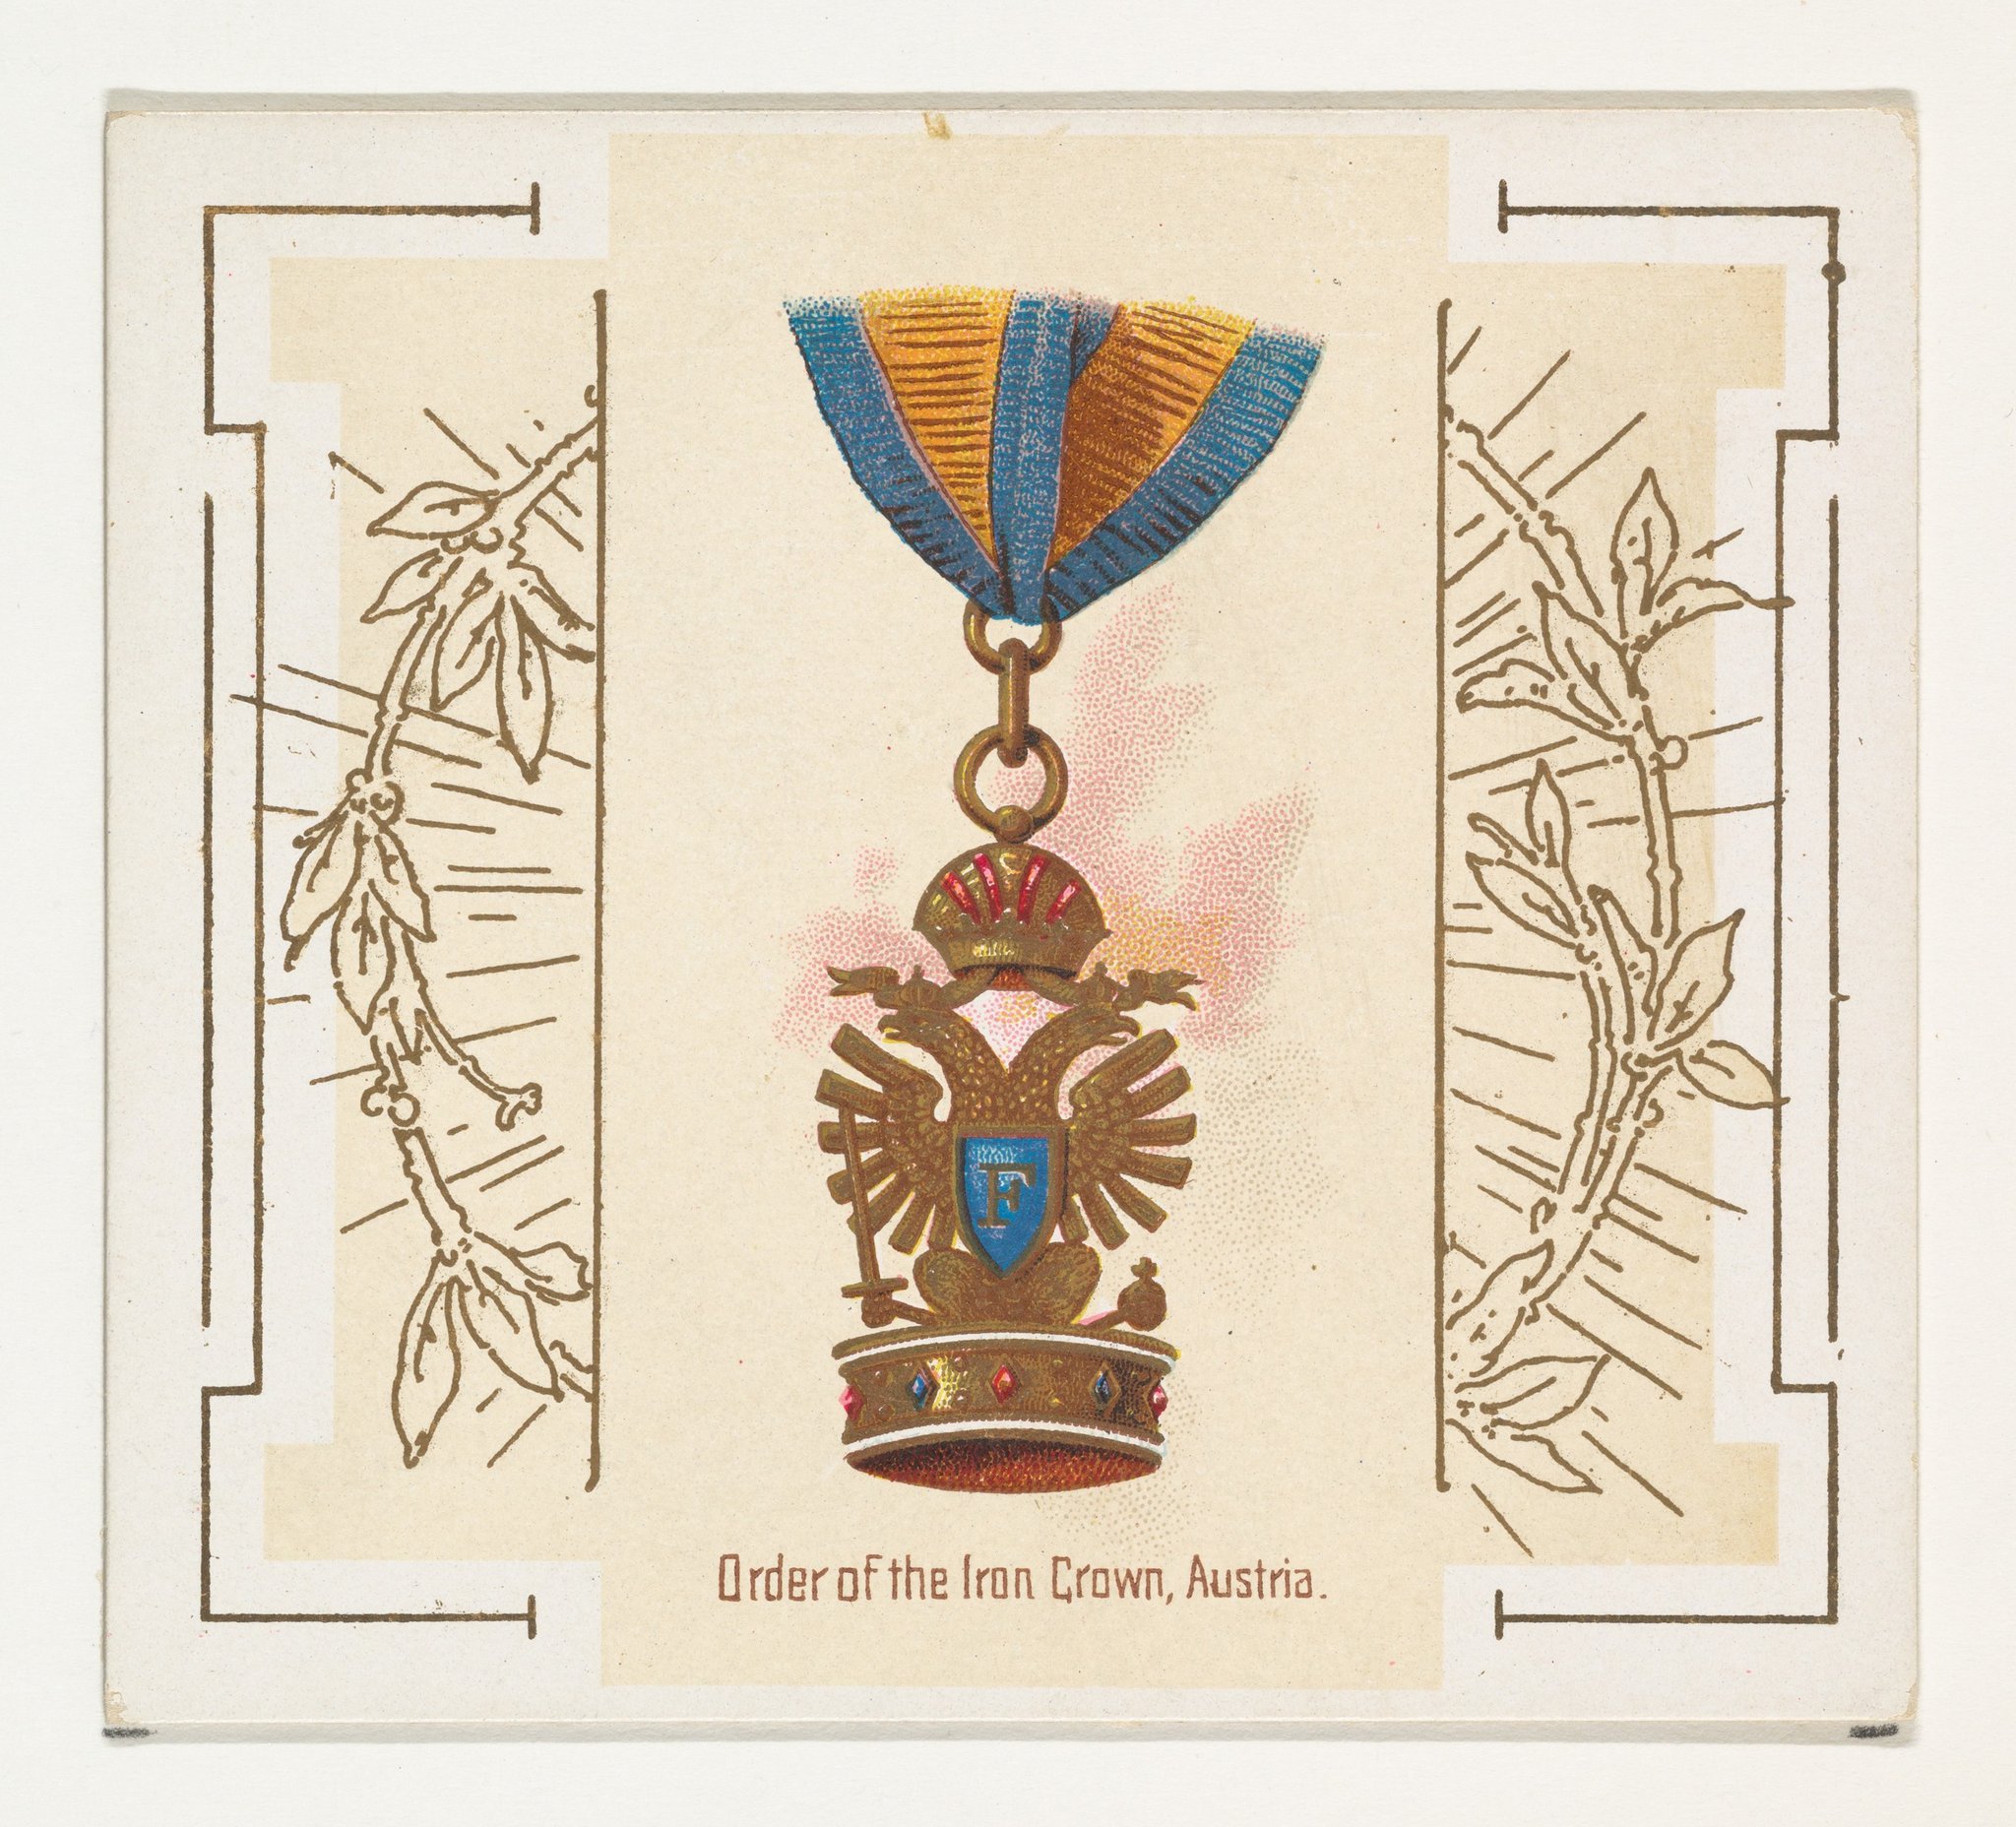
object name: print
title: Order of the Iron Crown, Austria, from the World's Decorations series (N44) for Allen & Ginter Cigarettes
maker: allen & ginter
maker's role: publisher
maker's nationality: american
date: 1890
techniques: color lithograph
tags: medals